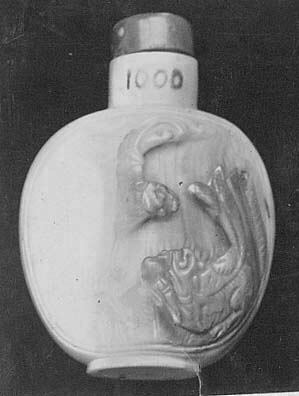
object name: snuff bottle with stopper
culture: chinese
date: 1701-1900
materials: coral, mother of pearl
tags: animals,bats